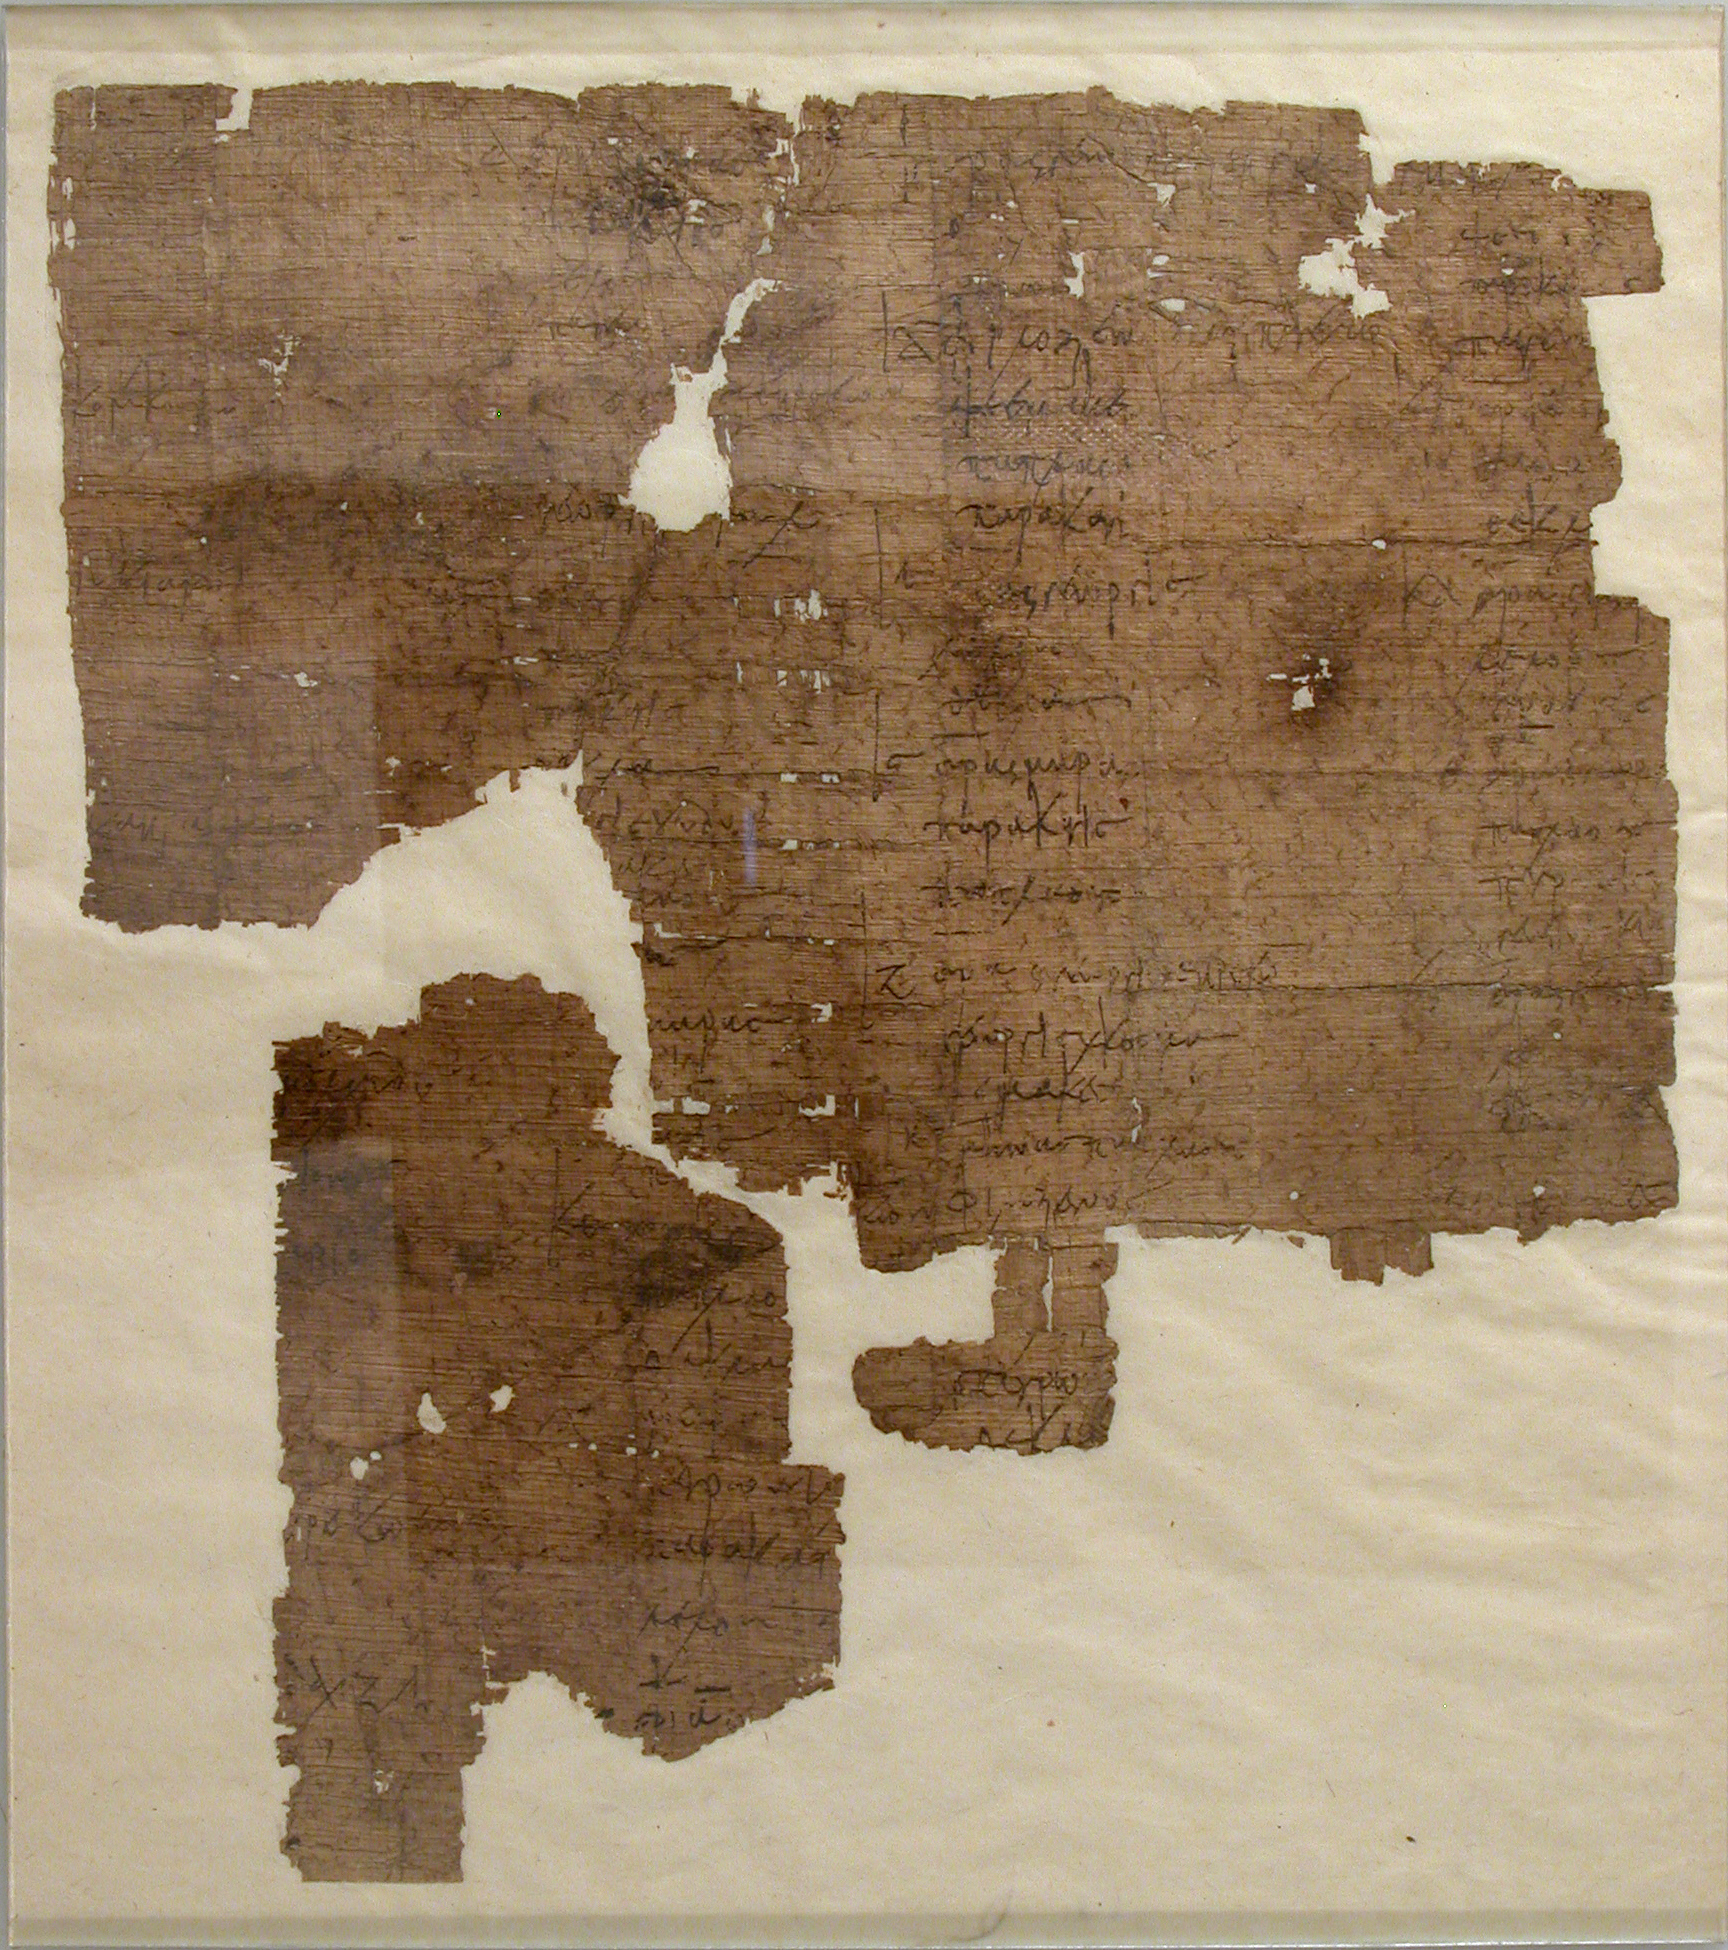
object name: fragment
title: Papyrus Fragment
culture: coptic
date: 601-700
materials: ink, papyrus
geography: egypt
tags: greek